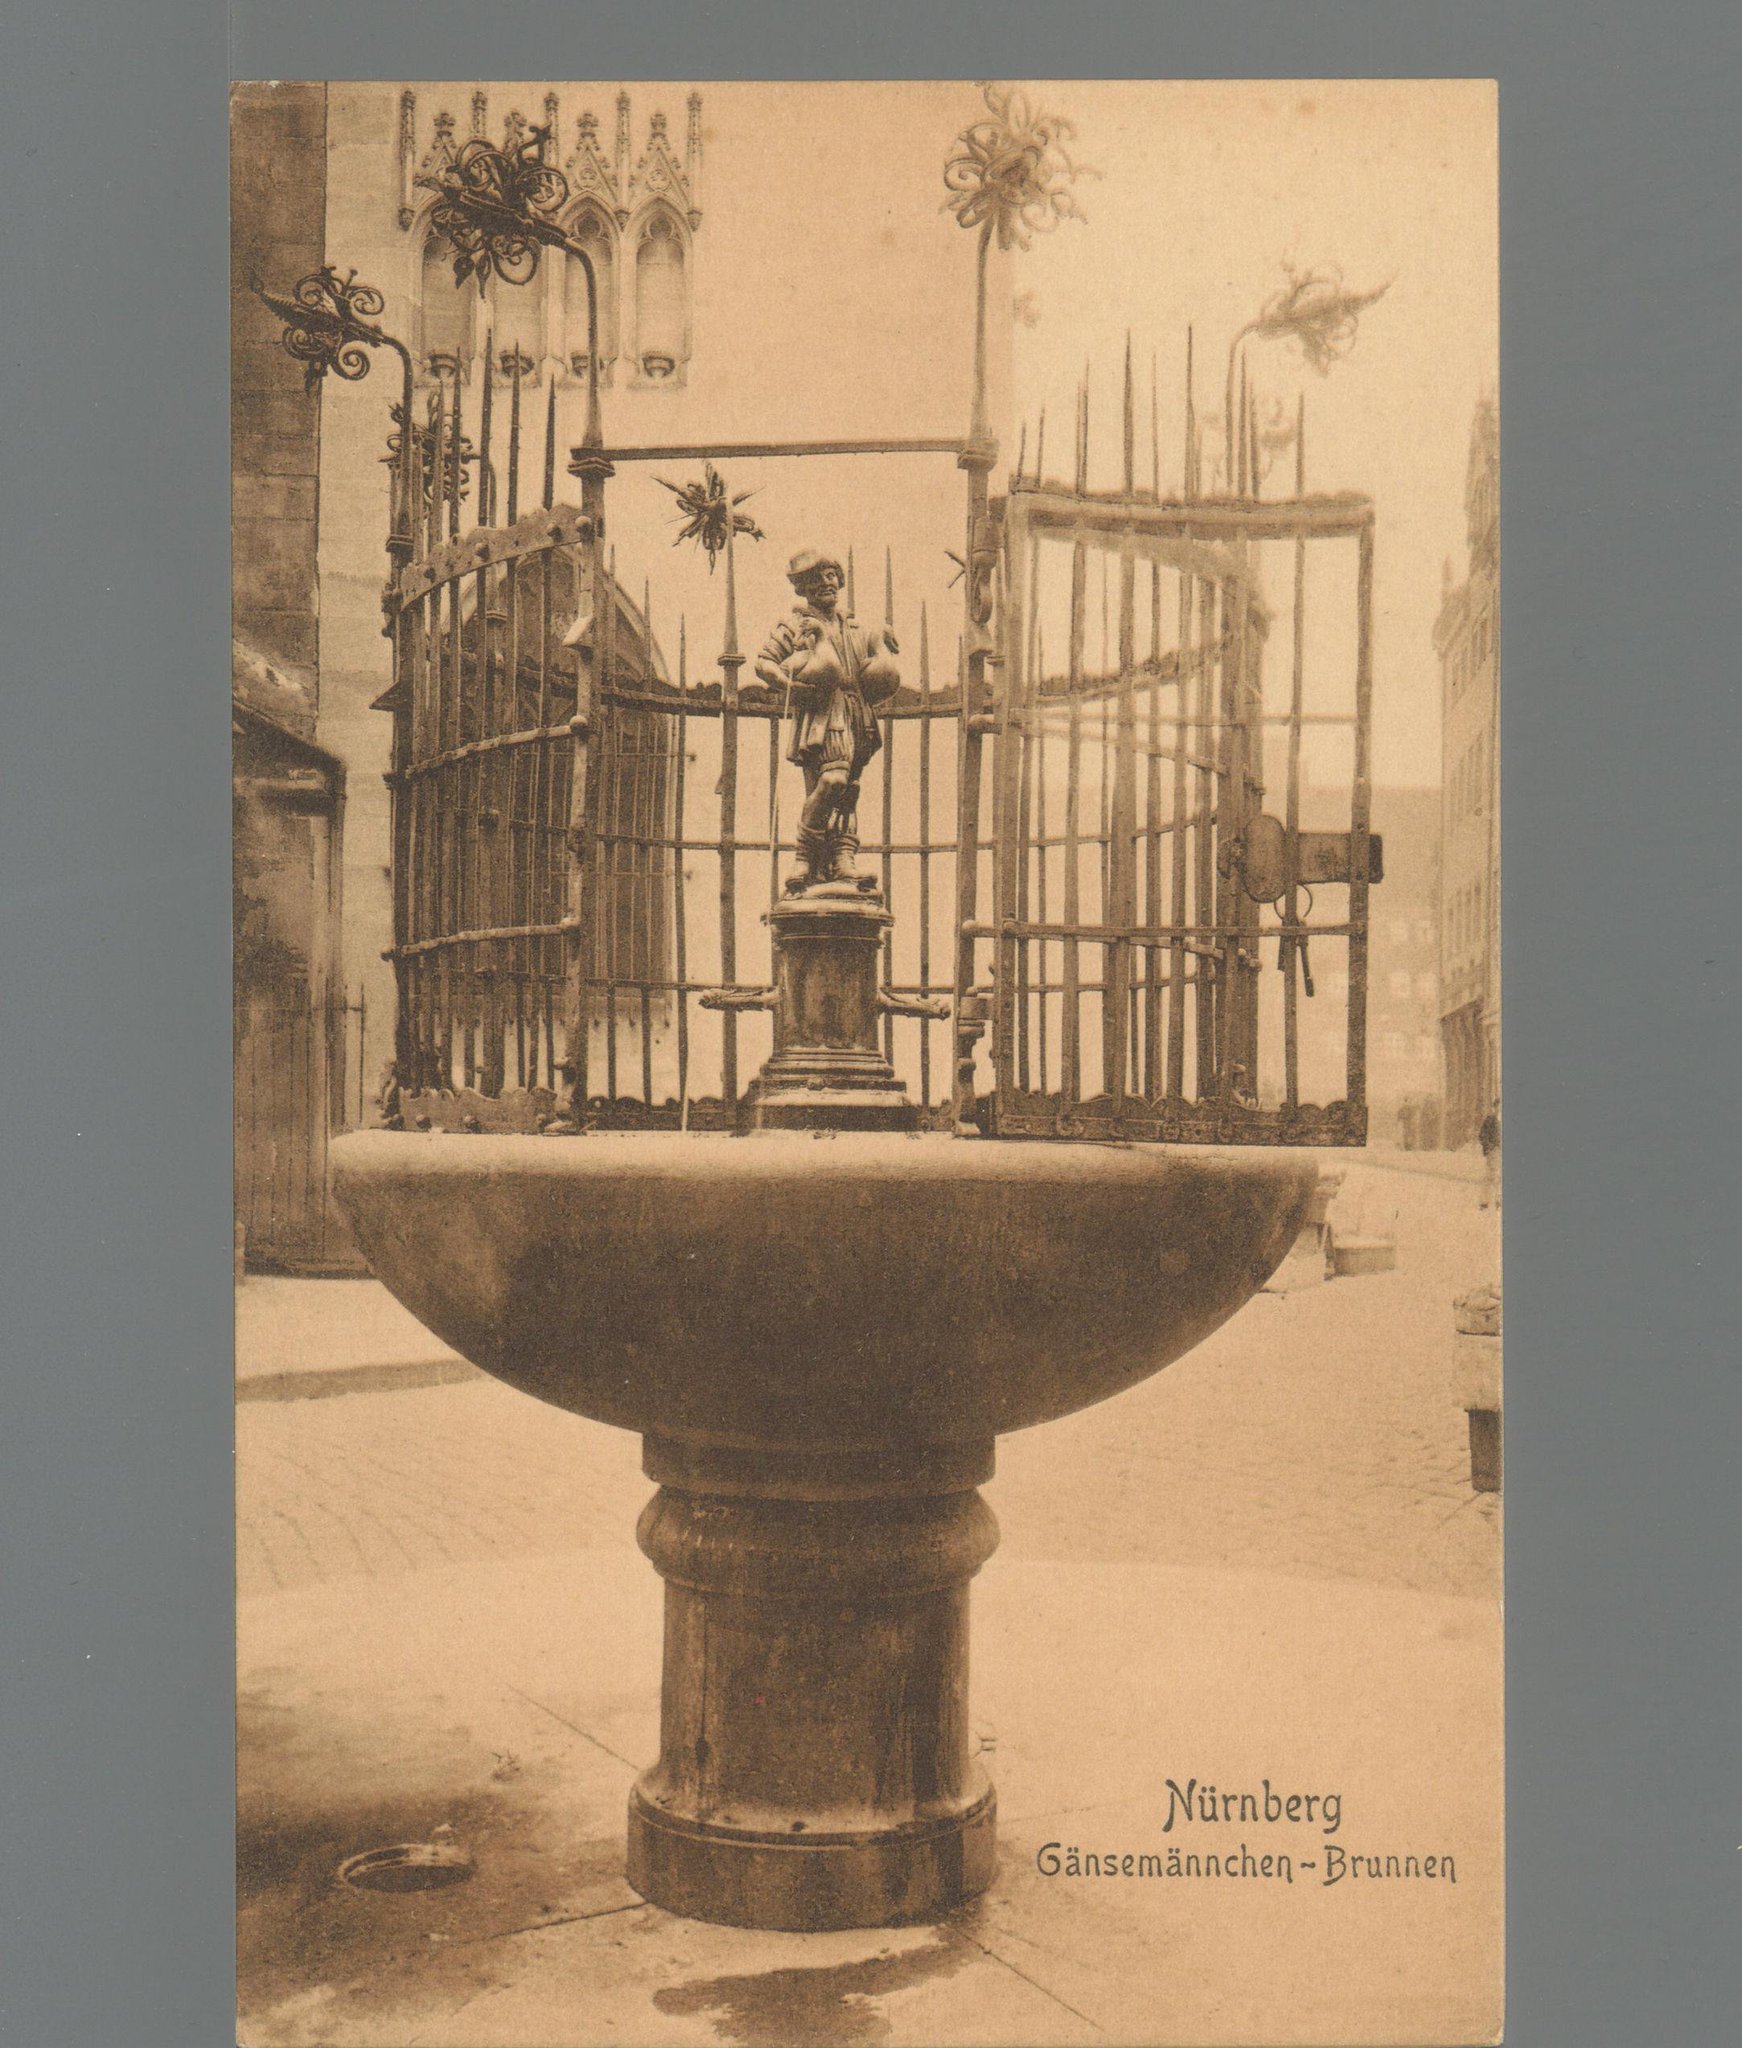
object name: ansichtkaart, prentbriefkaart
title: Nürnberg. Gänsemännchen-Brunnen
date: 1905-1909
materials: cardboard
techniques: photograph, writing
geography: nuremberg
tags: ornamental fountain